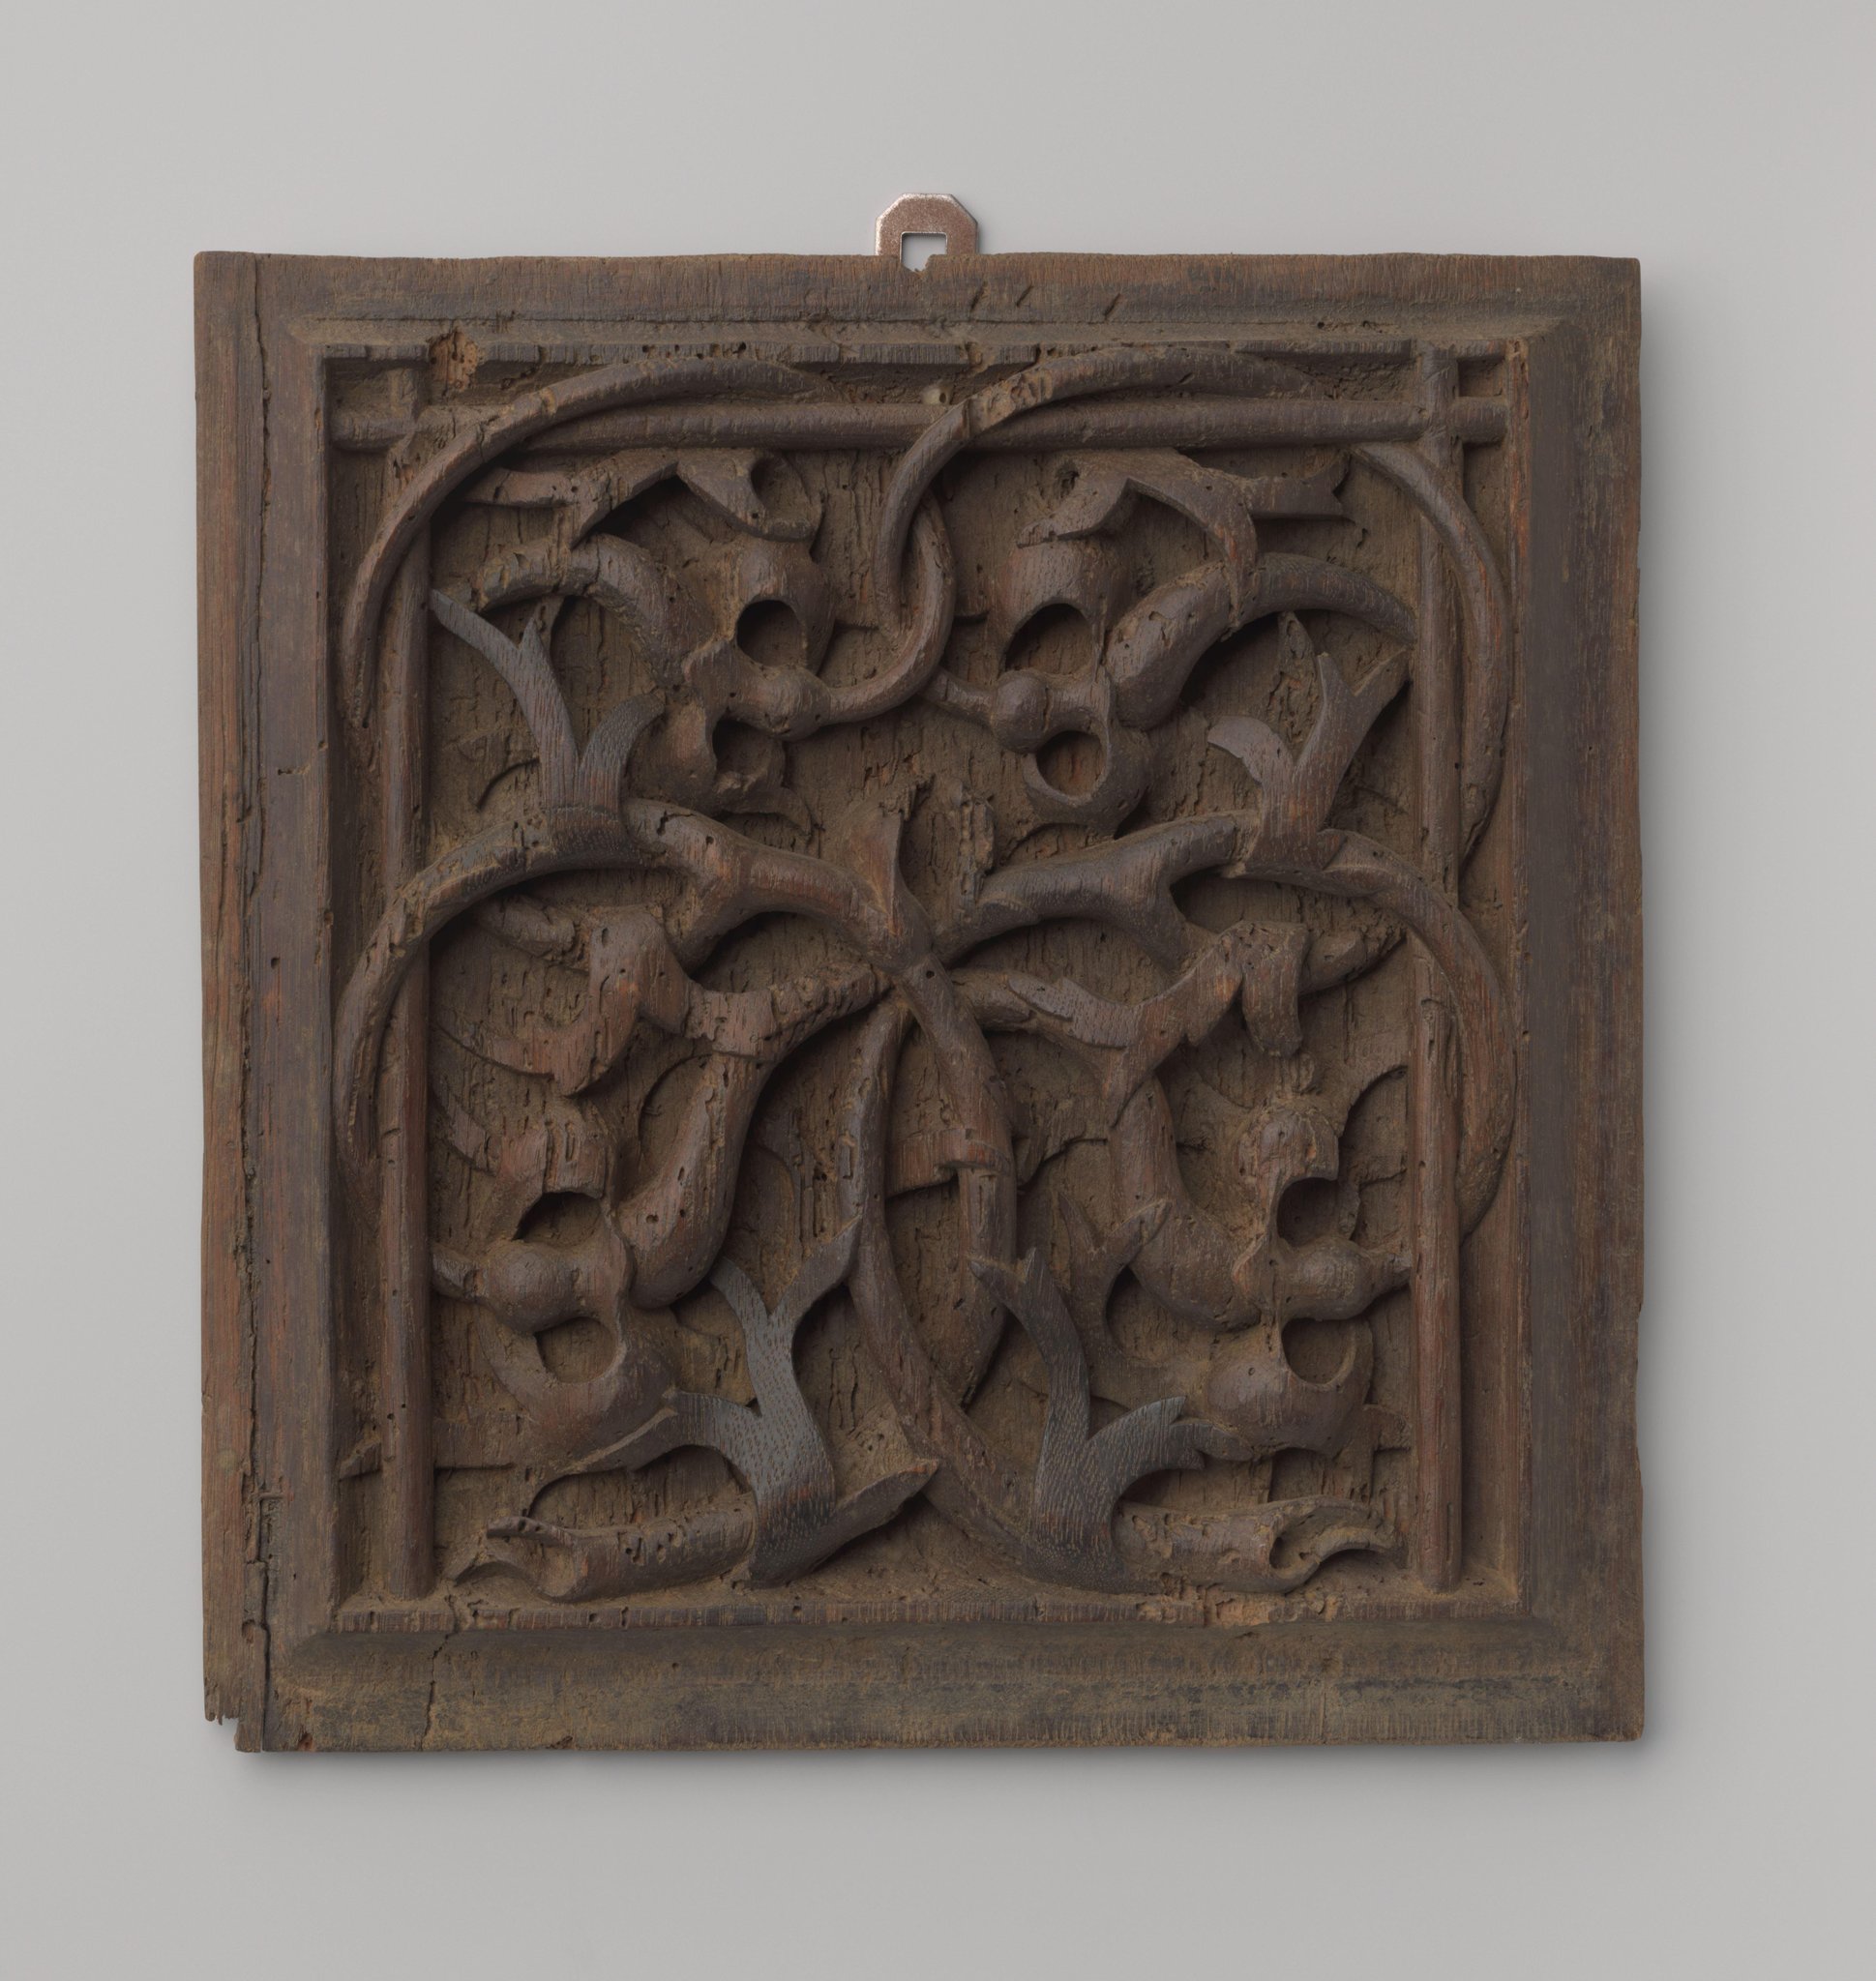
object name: door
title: Deurtje van een kast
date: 1500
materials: wood